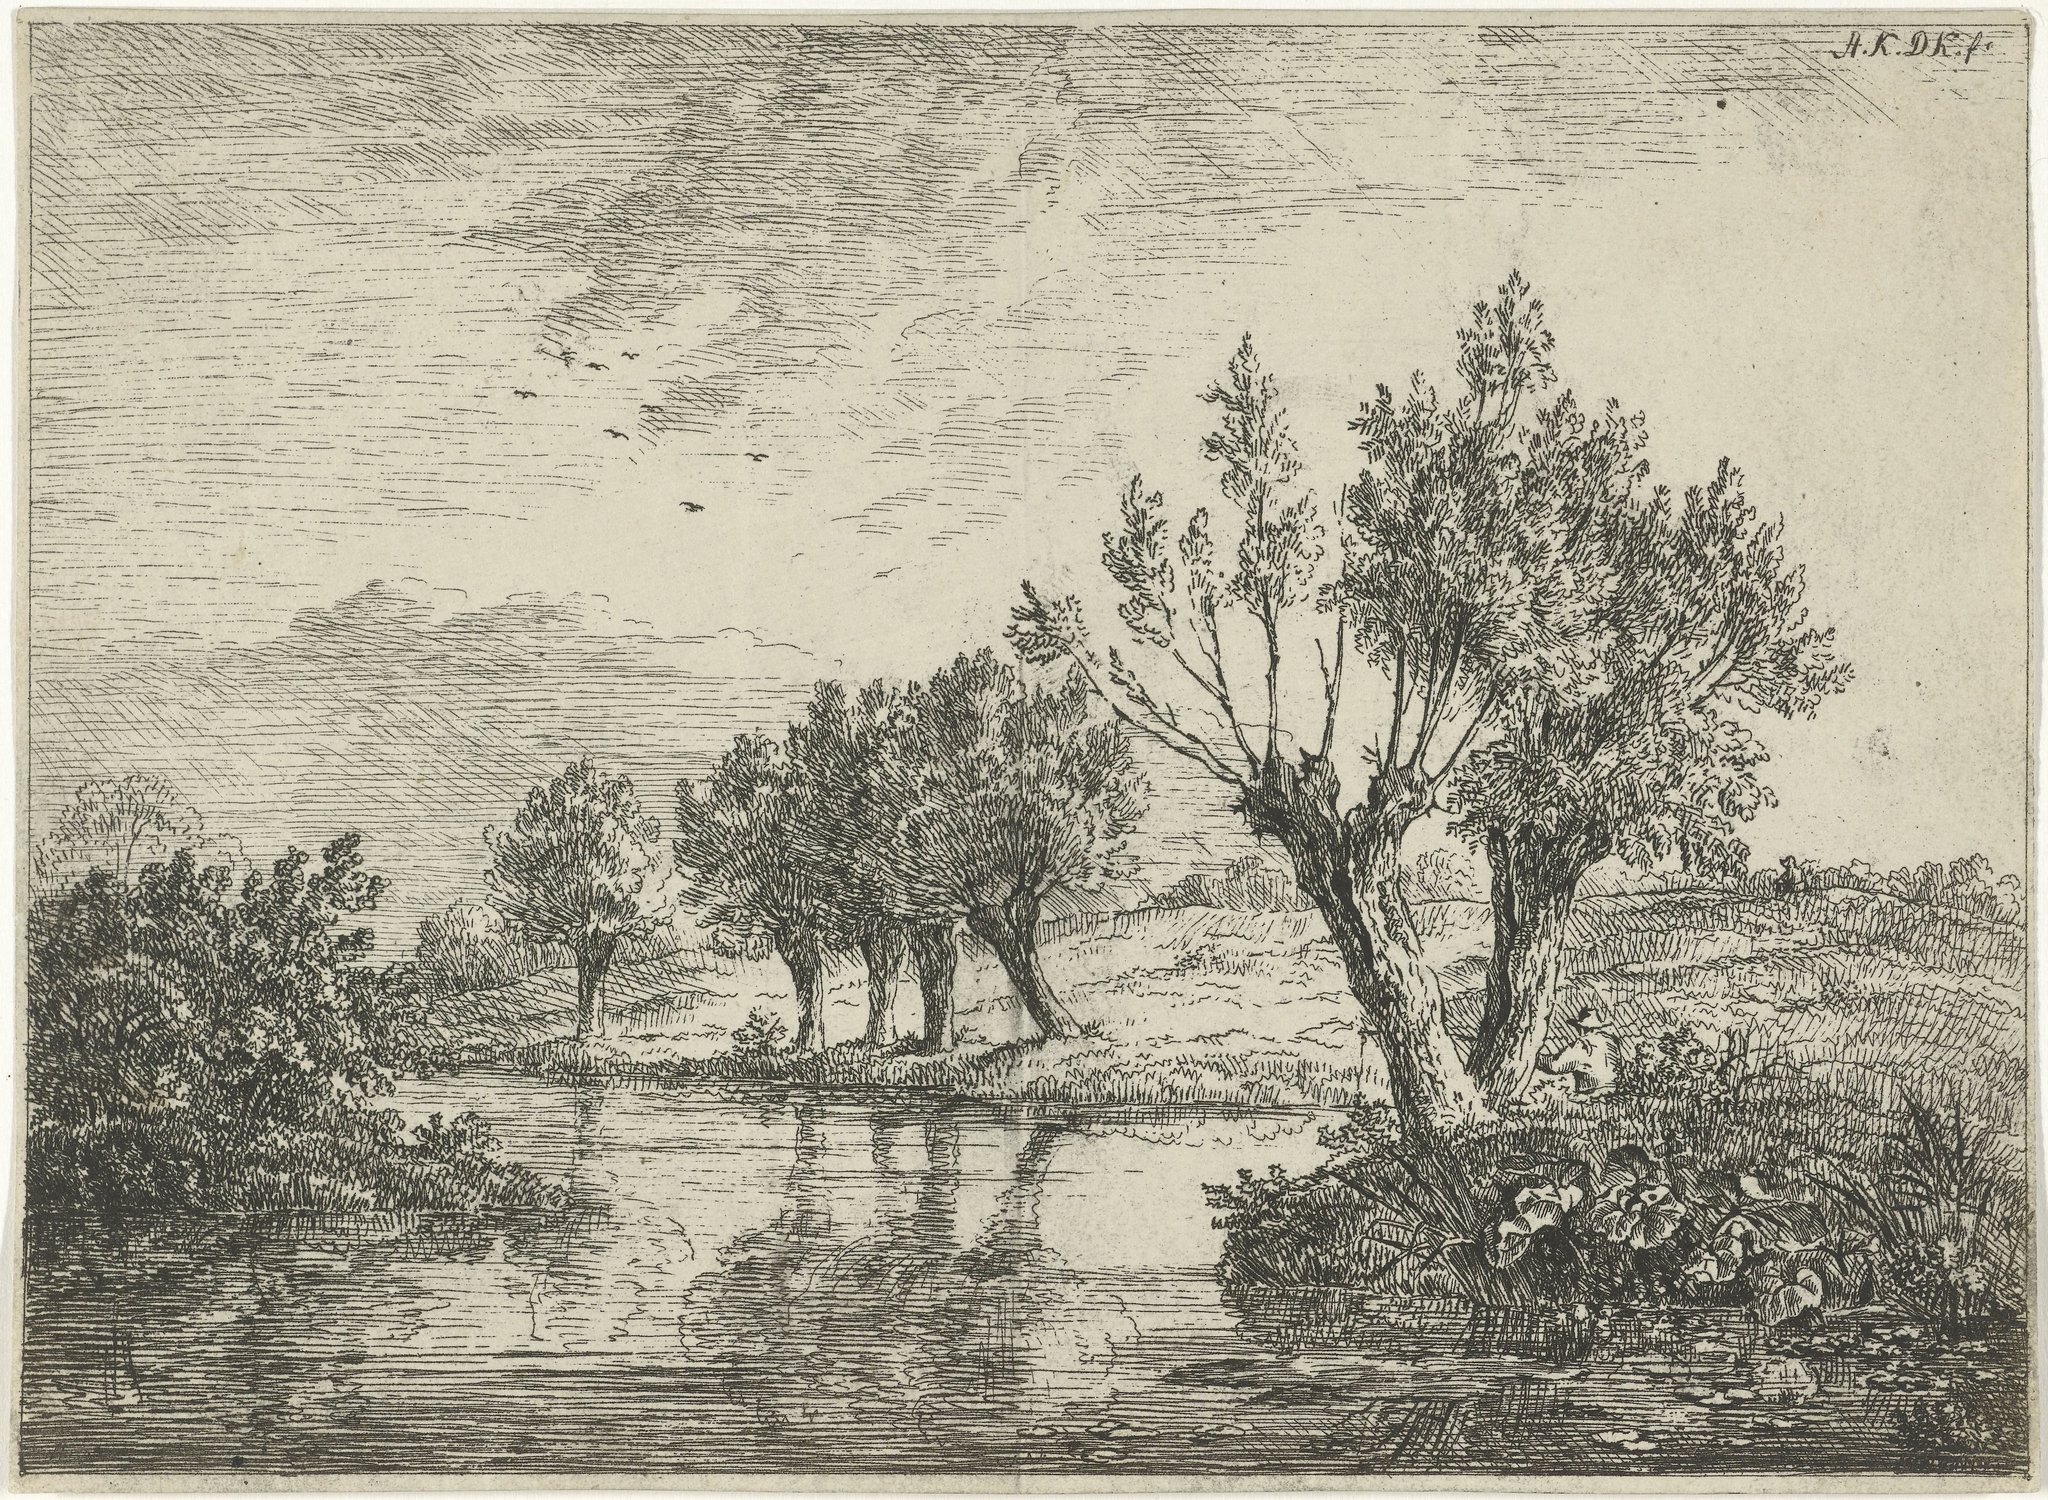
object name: print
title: Gezicht op een rivierlandschap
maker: arie ketting de koningh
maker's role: print maker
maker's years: 1815-1867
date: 1825-1867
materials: paper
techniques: etching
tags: landscapes, river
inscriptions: collector's mark: Lugt 2228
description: Rivierlandschap met rechts aan de waterkant enkele knotwilgen en een visser.